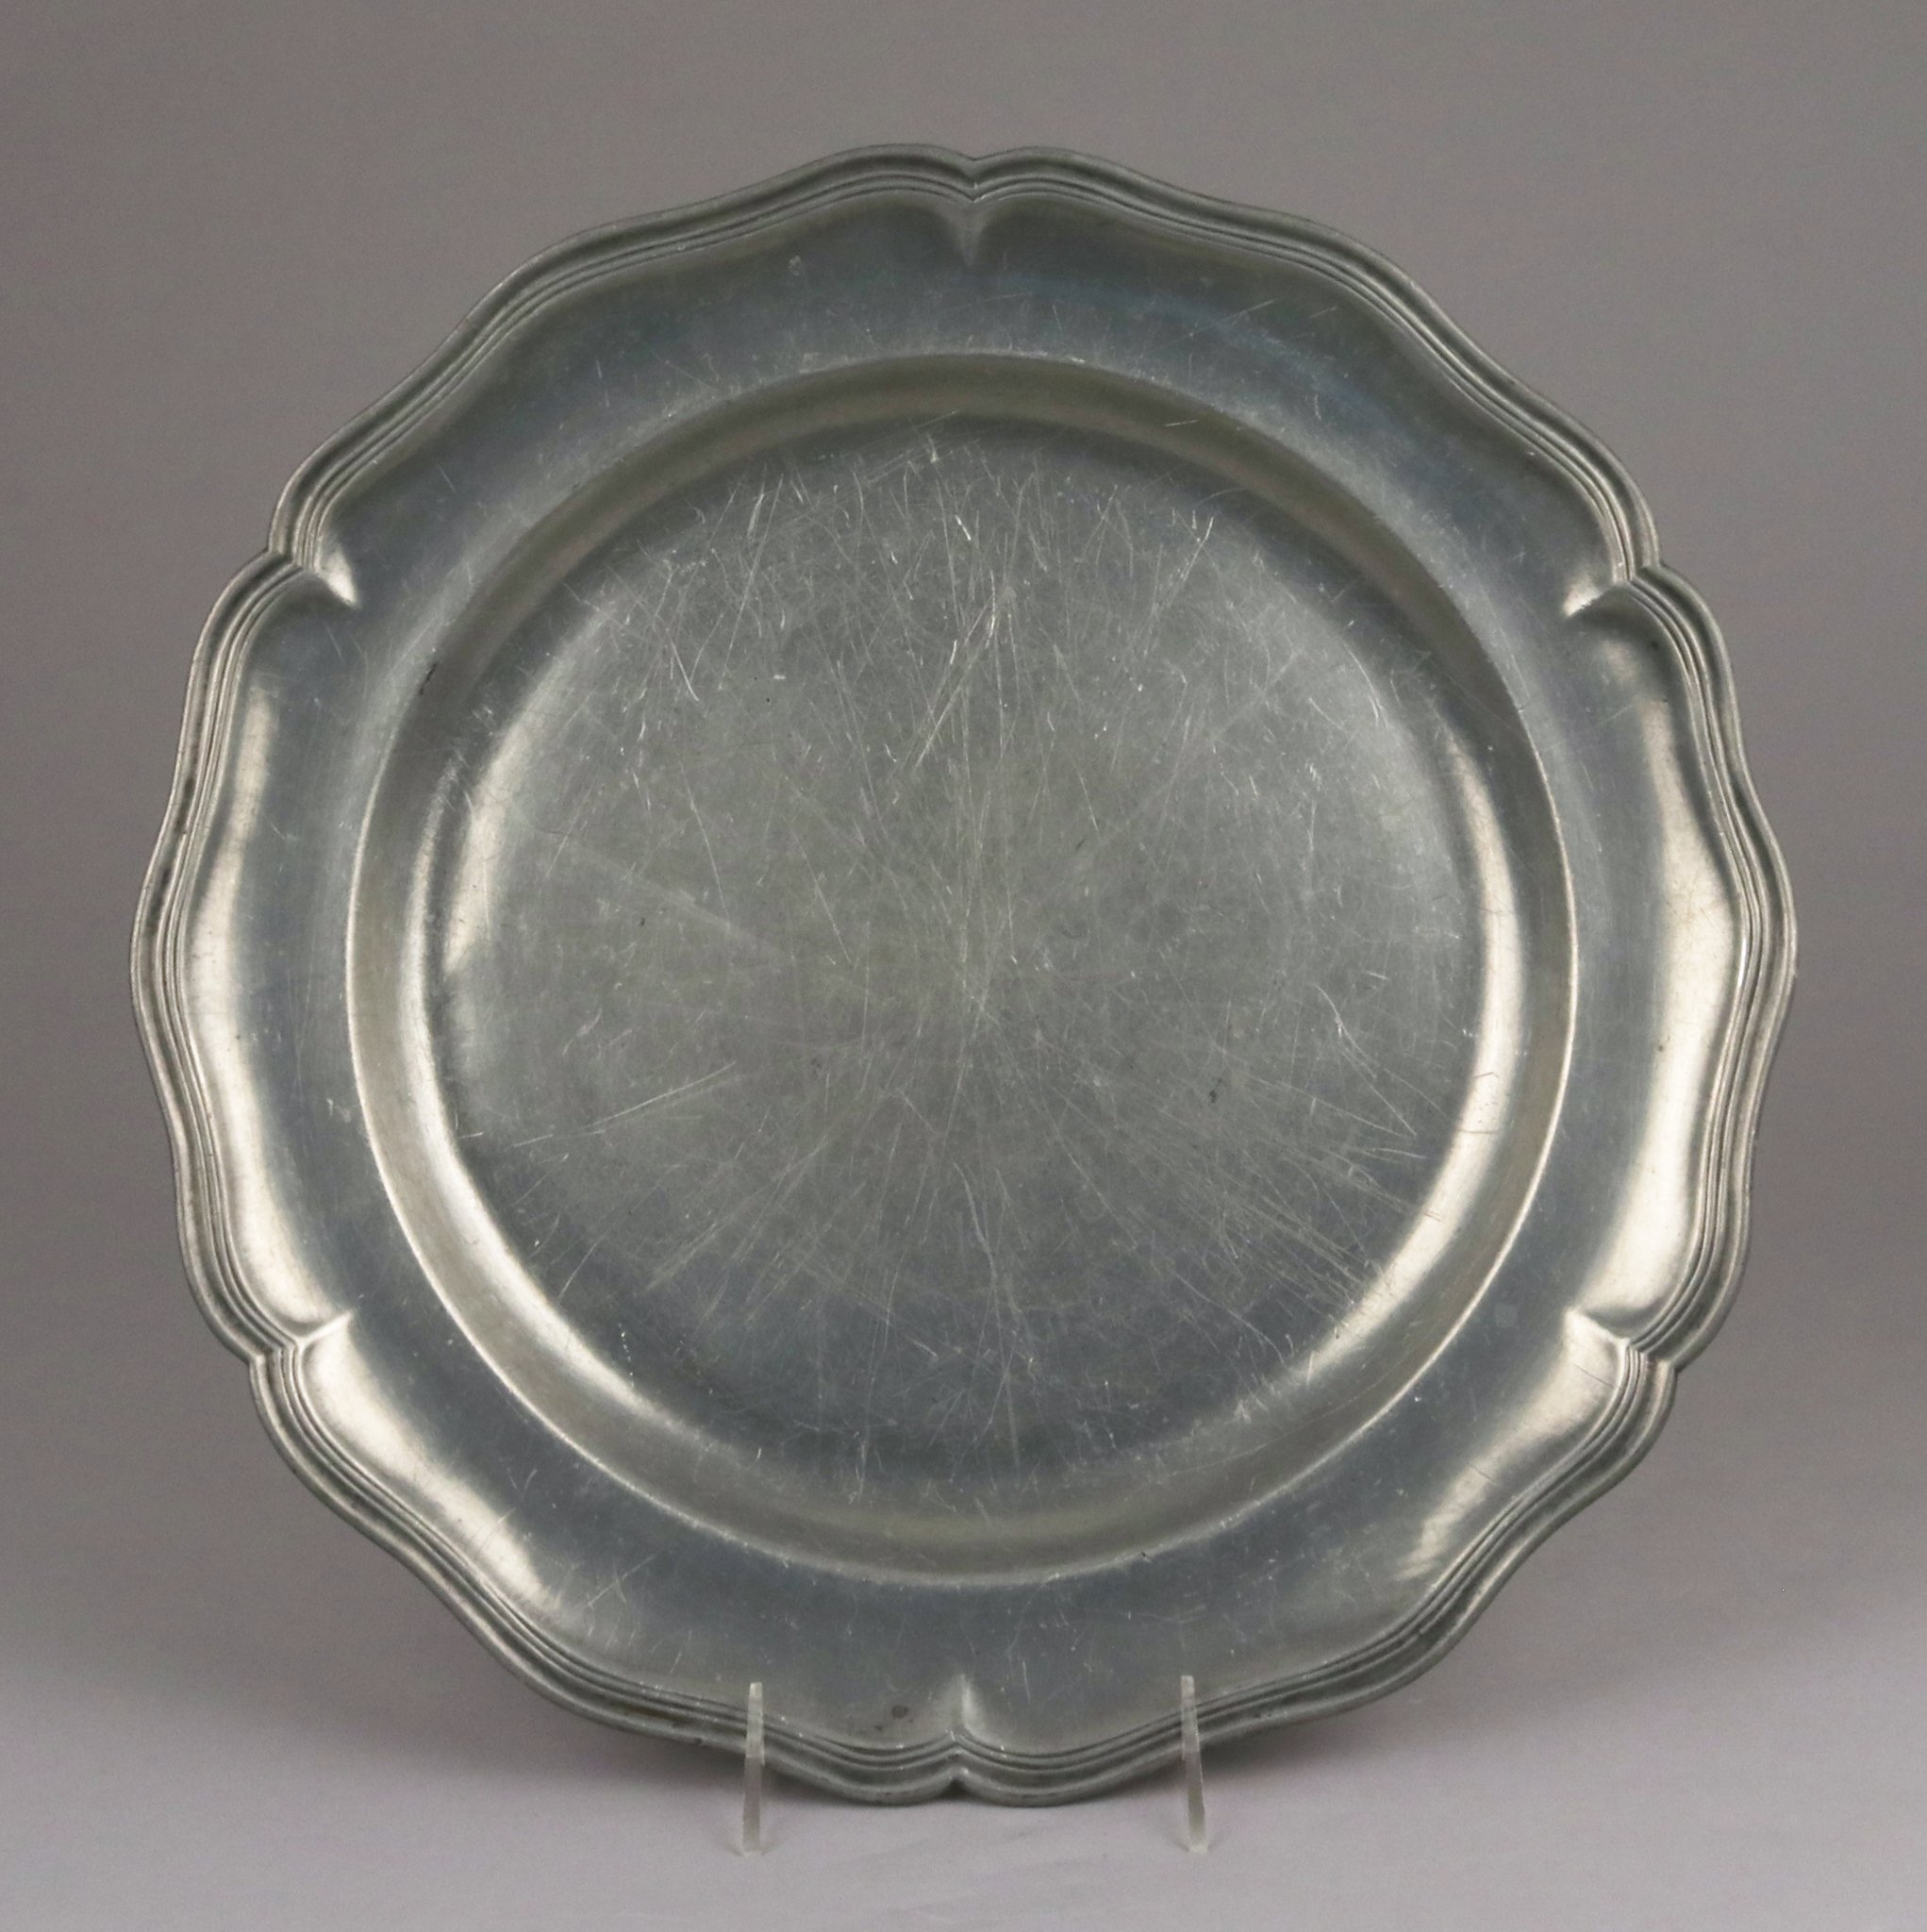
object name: dish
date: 1701-1800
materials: pewter